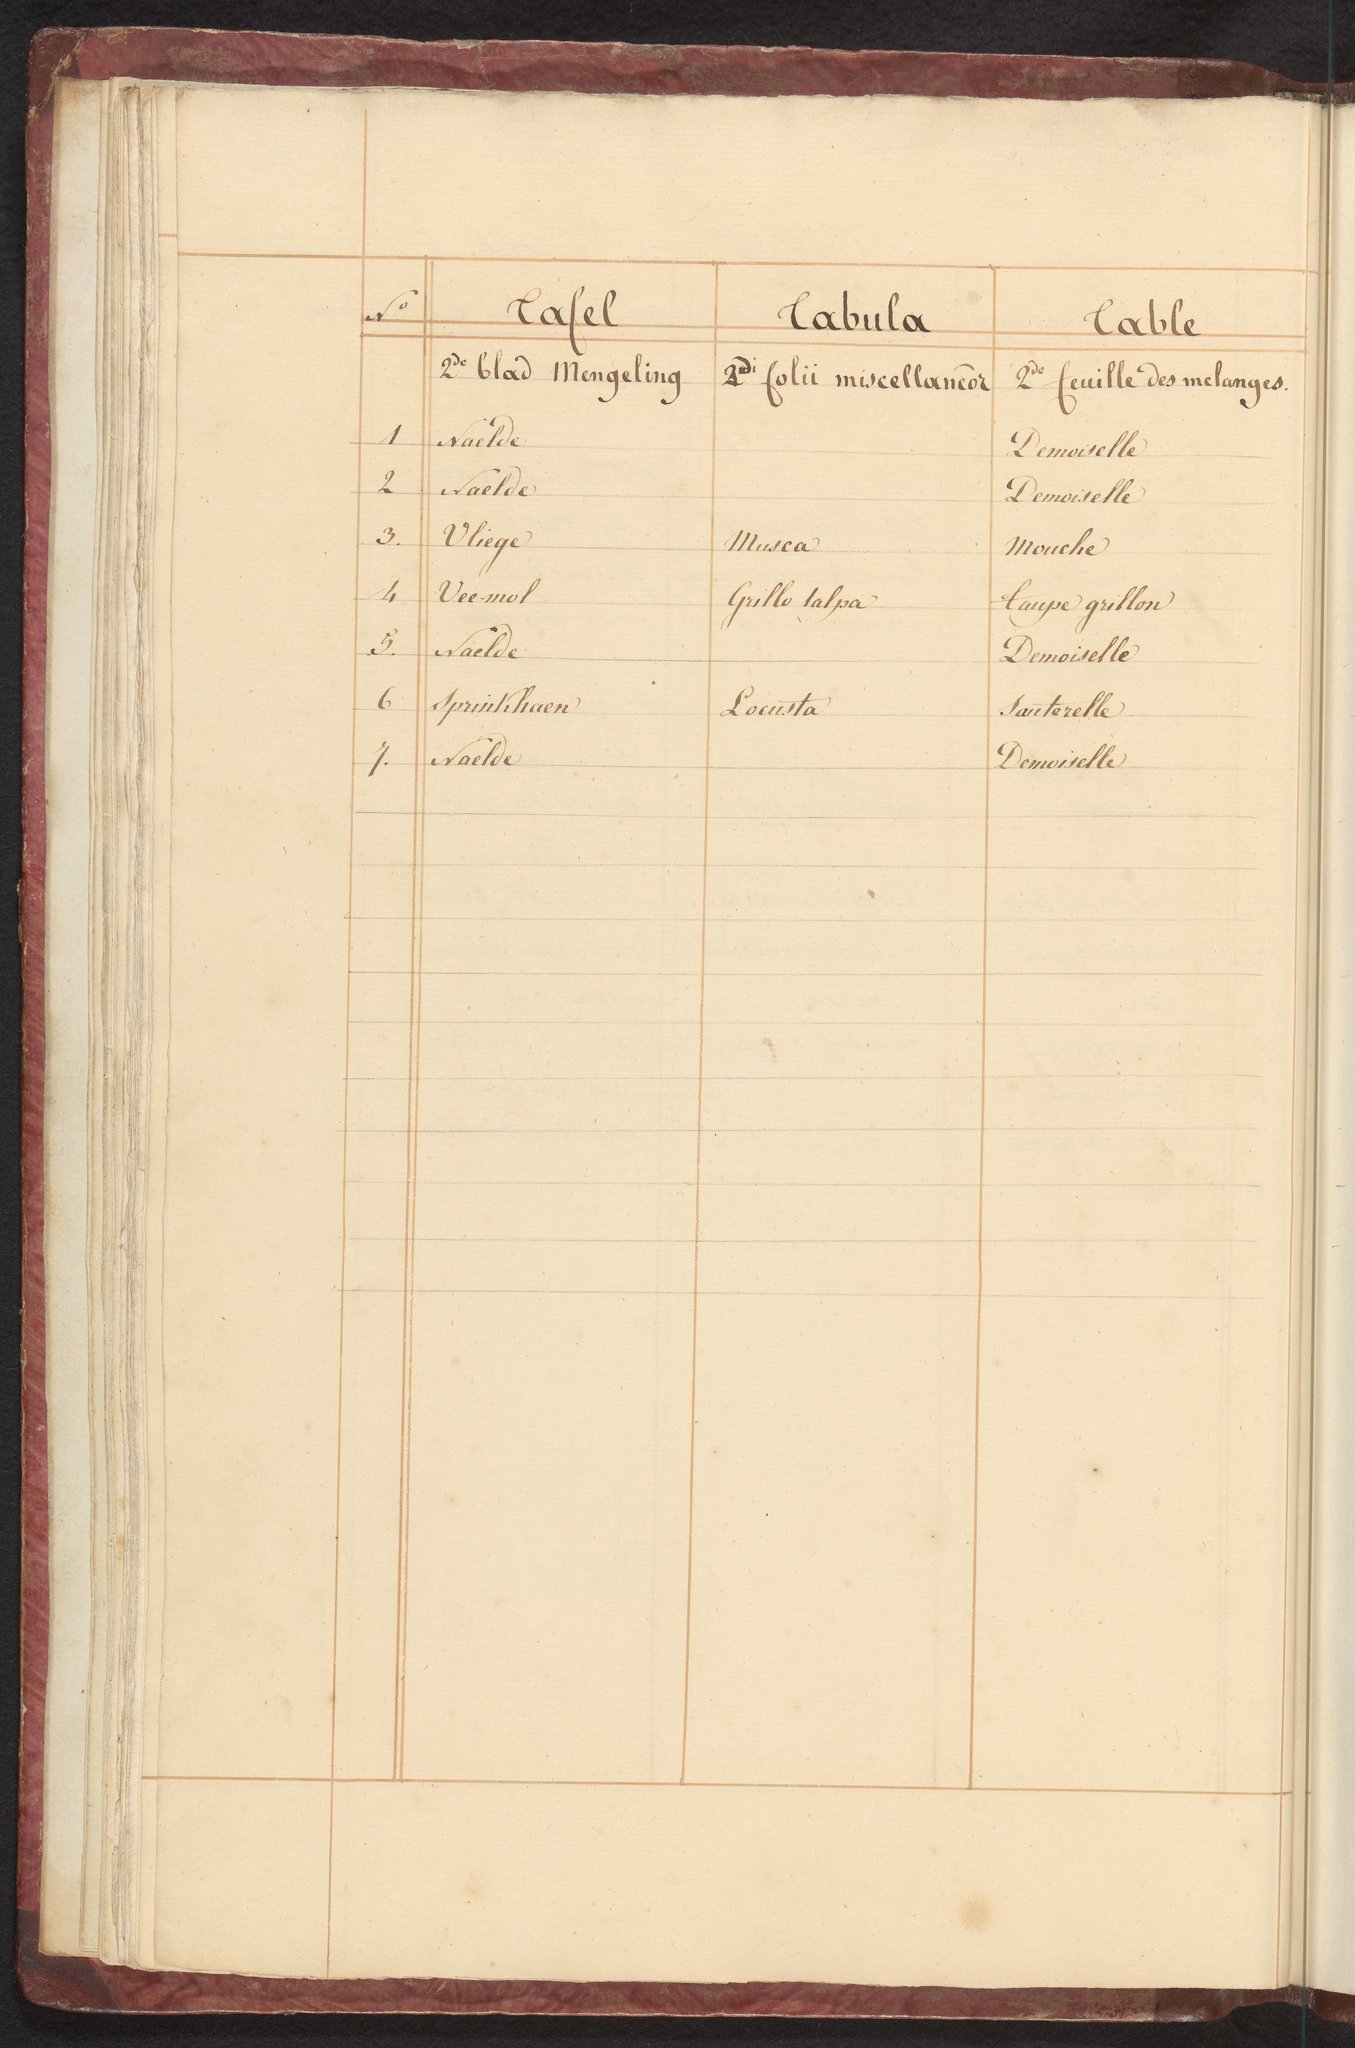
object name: manuscript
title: Lijst van dieren en planten in het tweede ensemble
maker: joseph van huerne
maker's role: kunstliefhebber, mecenas, verzamelaar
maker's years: 1752-1844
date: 1809-1814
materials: ink, paper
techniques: handwriting, pen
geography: bruges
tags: handwriting, written text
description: Schema met een lijst in drie kolommen van de dieren en planten afgebeeld in het tweede ensemble, nummers 1-7. Onderdeel van het zevende album met tekeningen van reptielen, amfibieën en natuurhistorische ensembles. Het zevende van twaalf albums met aquarellen van dieren, vogels en planten bekend rond 1600, gemaakt in opdracht van keizer Rudolf II. Met toelichting in Nederlands, Latijn en Frans.